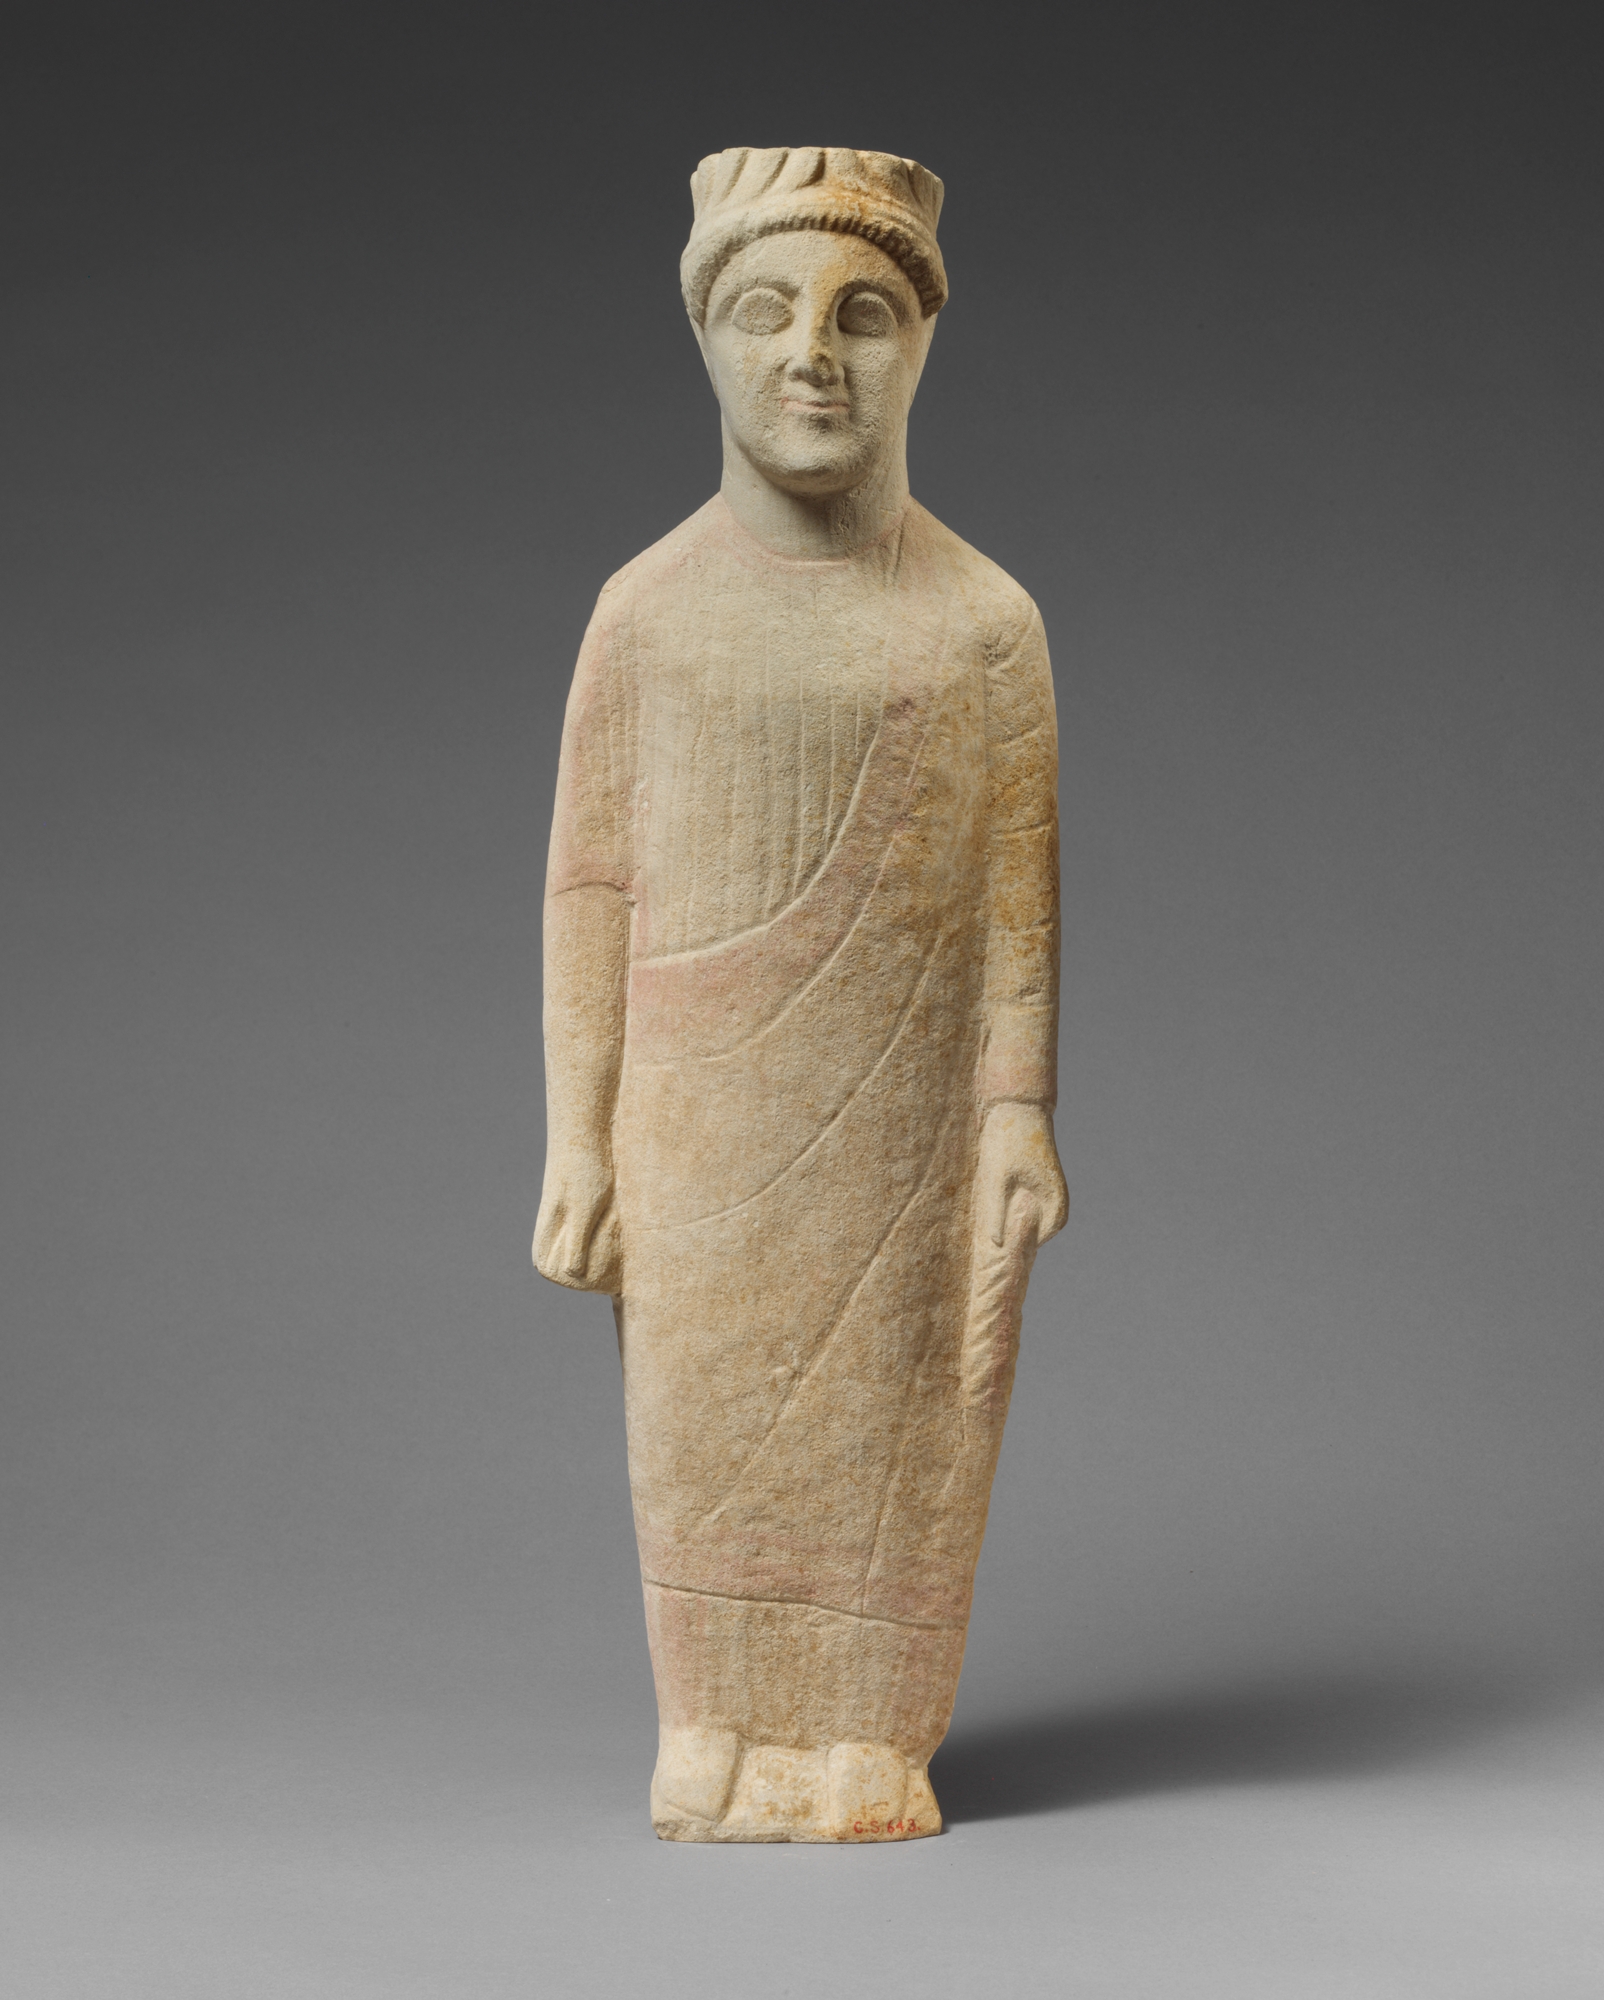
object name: statue of a votary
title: Limestone statuette of a beardless male votary with a wreath of leaves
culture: cypriot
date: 434-401 BCE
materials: limestone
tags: men,wreaths